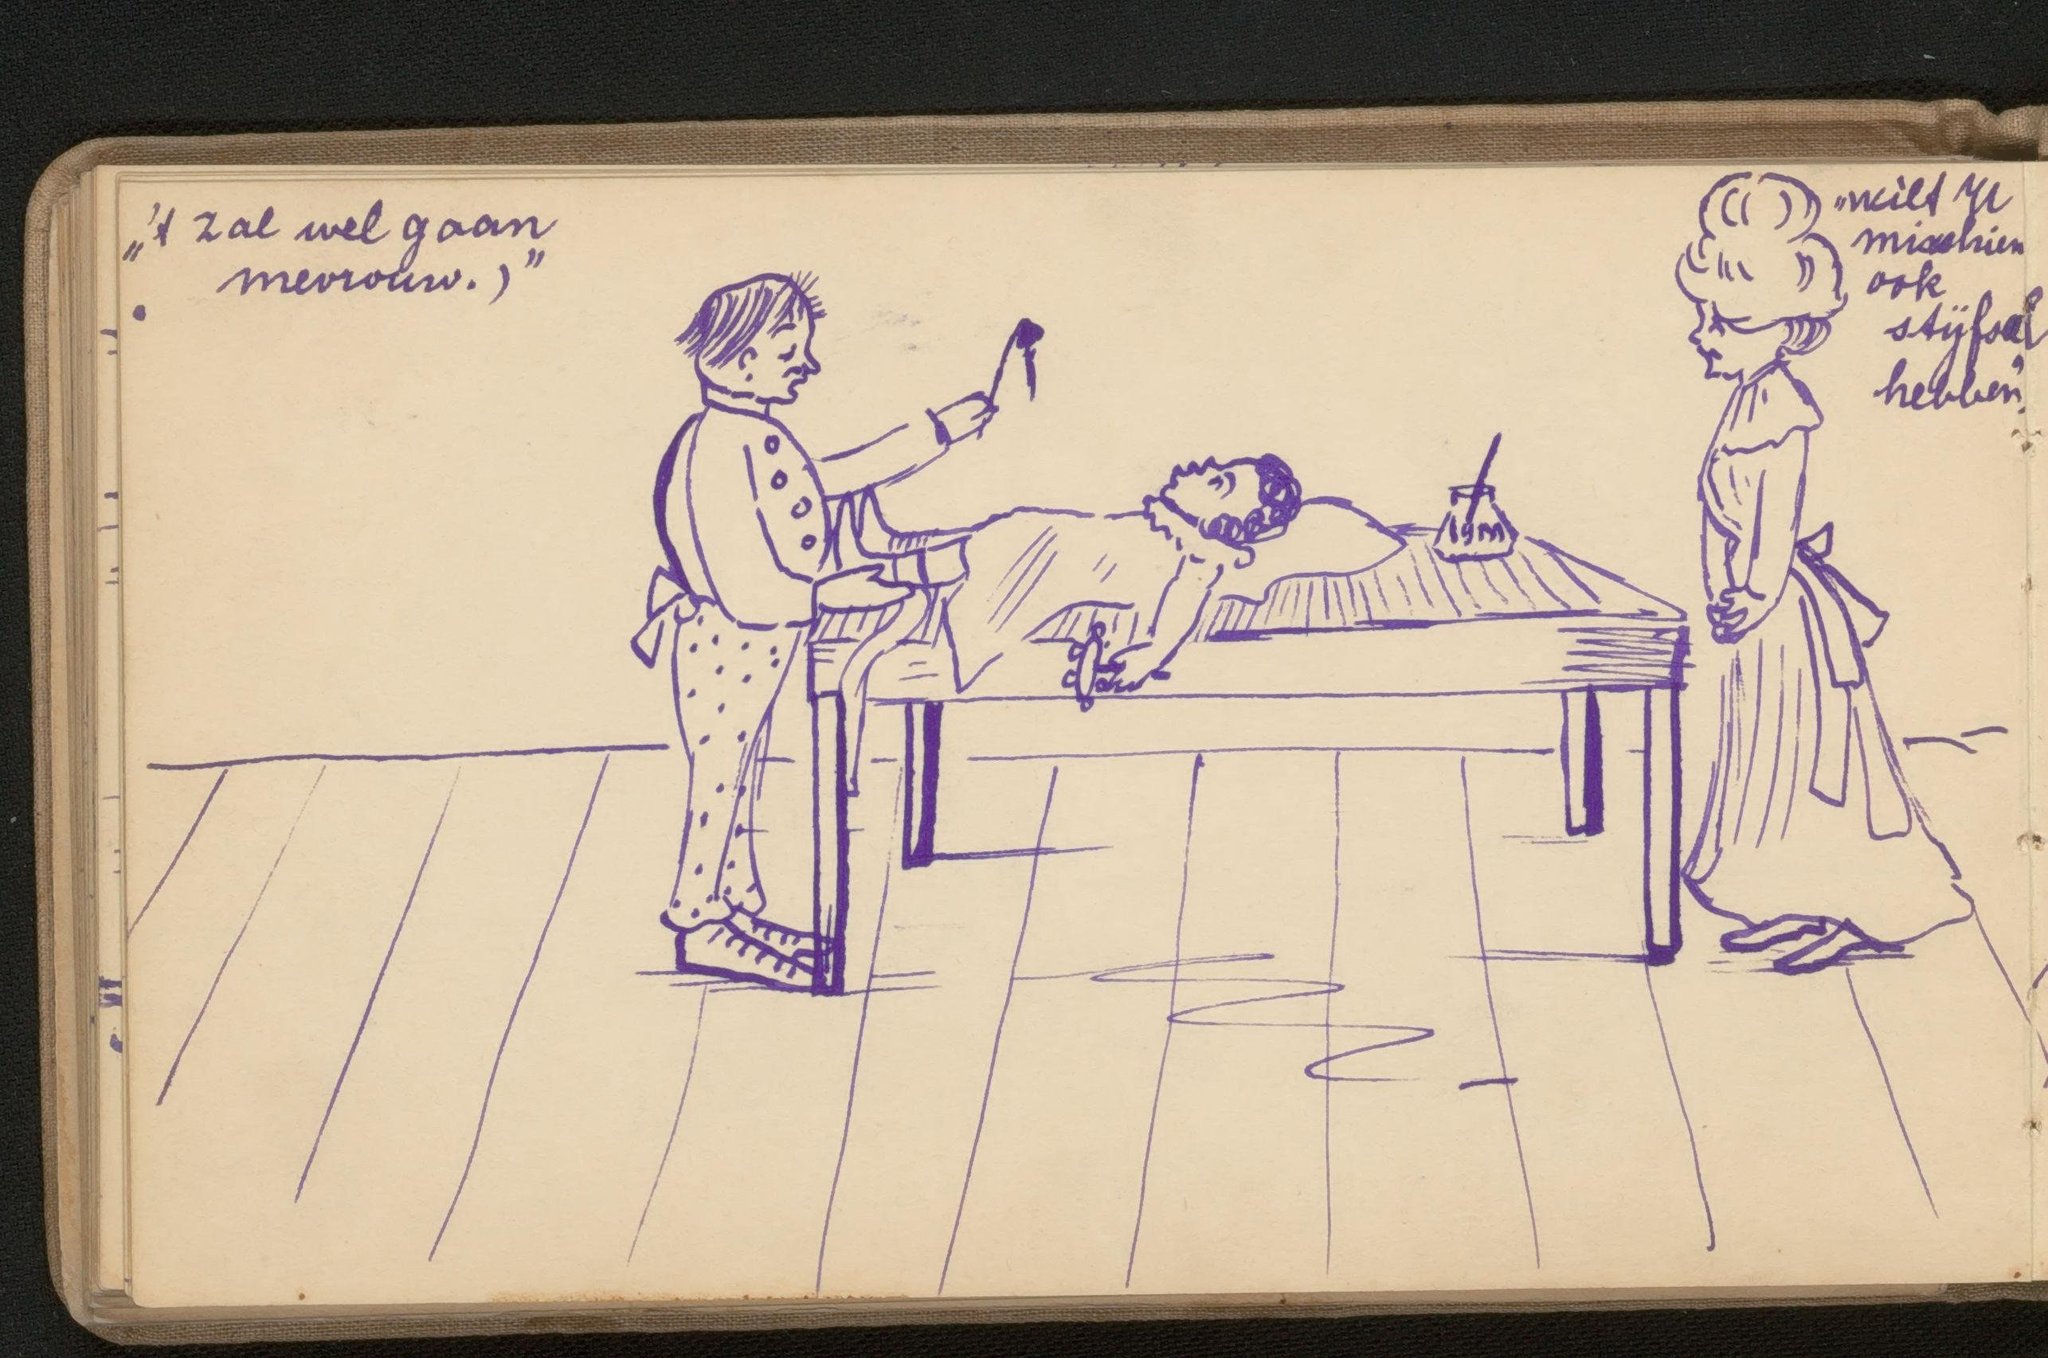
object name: sketchbook leaf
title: Het afgebroken been weer vastgelijmd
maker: Anonymous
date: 1875-1920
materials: ink, paper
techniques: pen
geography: netherlands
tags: infant, baby, parental love, healing of sick person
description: Het afgebroken been door de dokter weer vastgelijmd, Ma vraagt of hij ook stijfsel nodig heeft. Onderdeel van het schetsboek met humoristische tekeningen over het leven van een 'famille nombreuse'. Onderwerpsrubrieken binnen de Atlas Zeden en Gewoonten: Zeden en Gewoonten in Engeren Zin, Des menschen beging, midden en einde, Kinderleven.